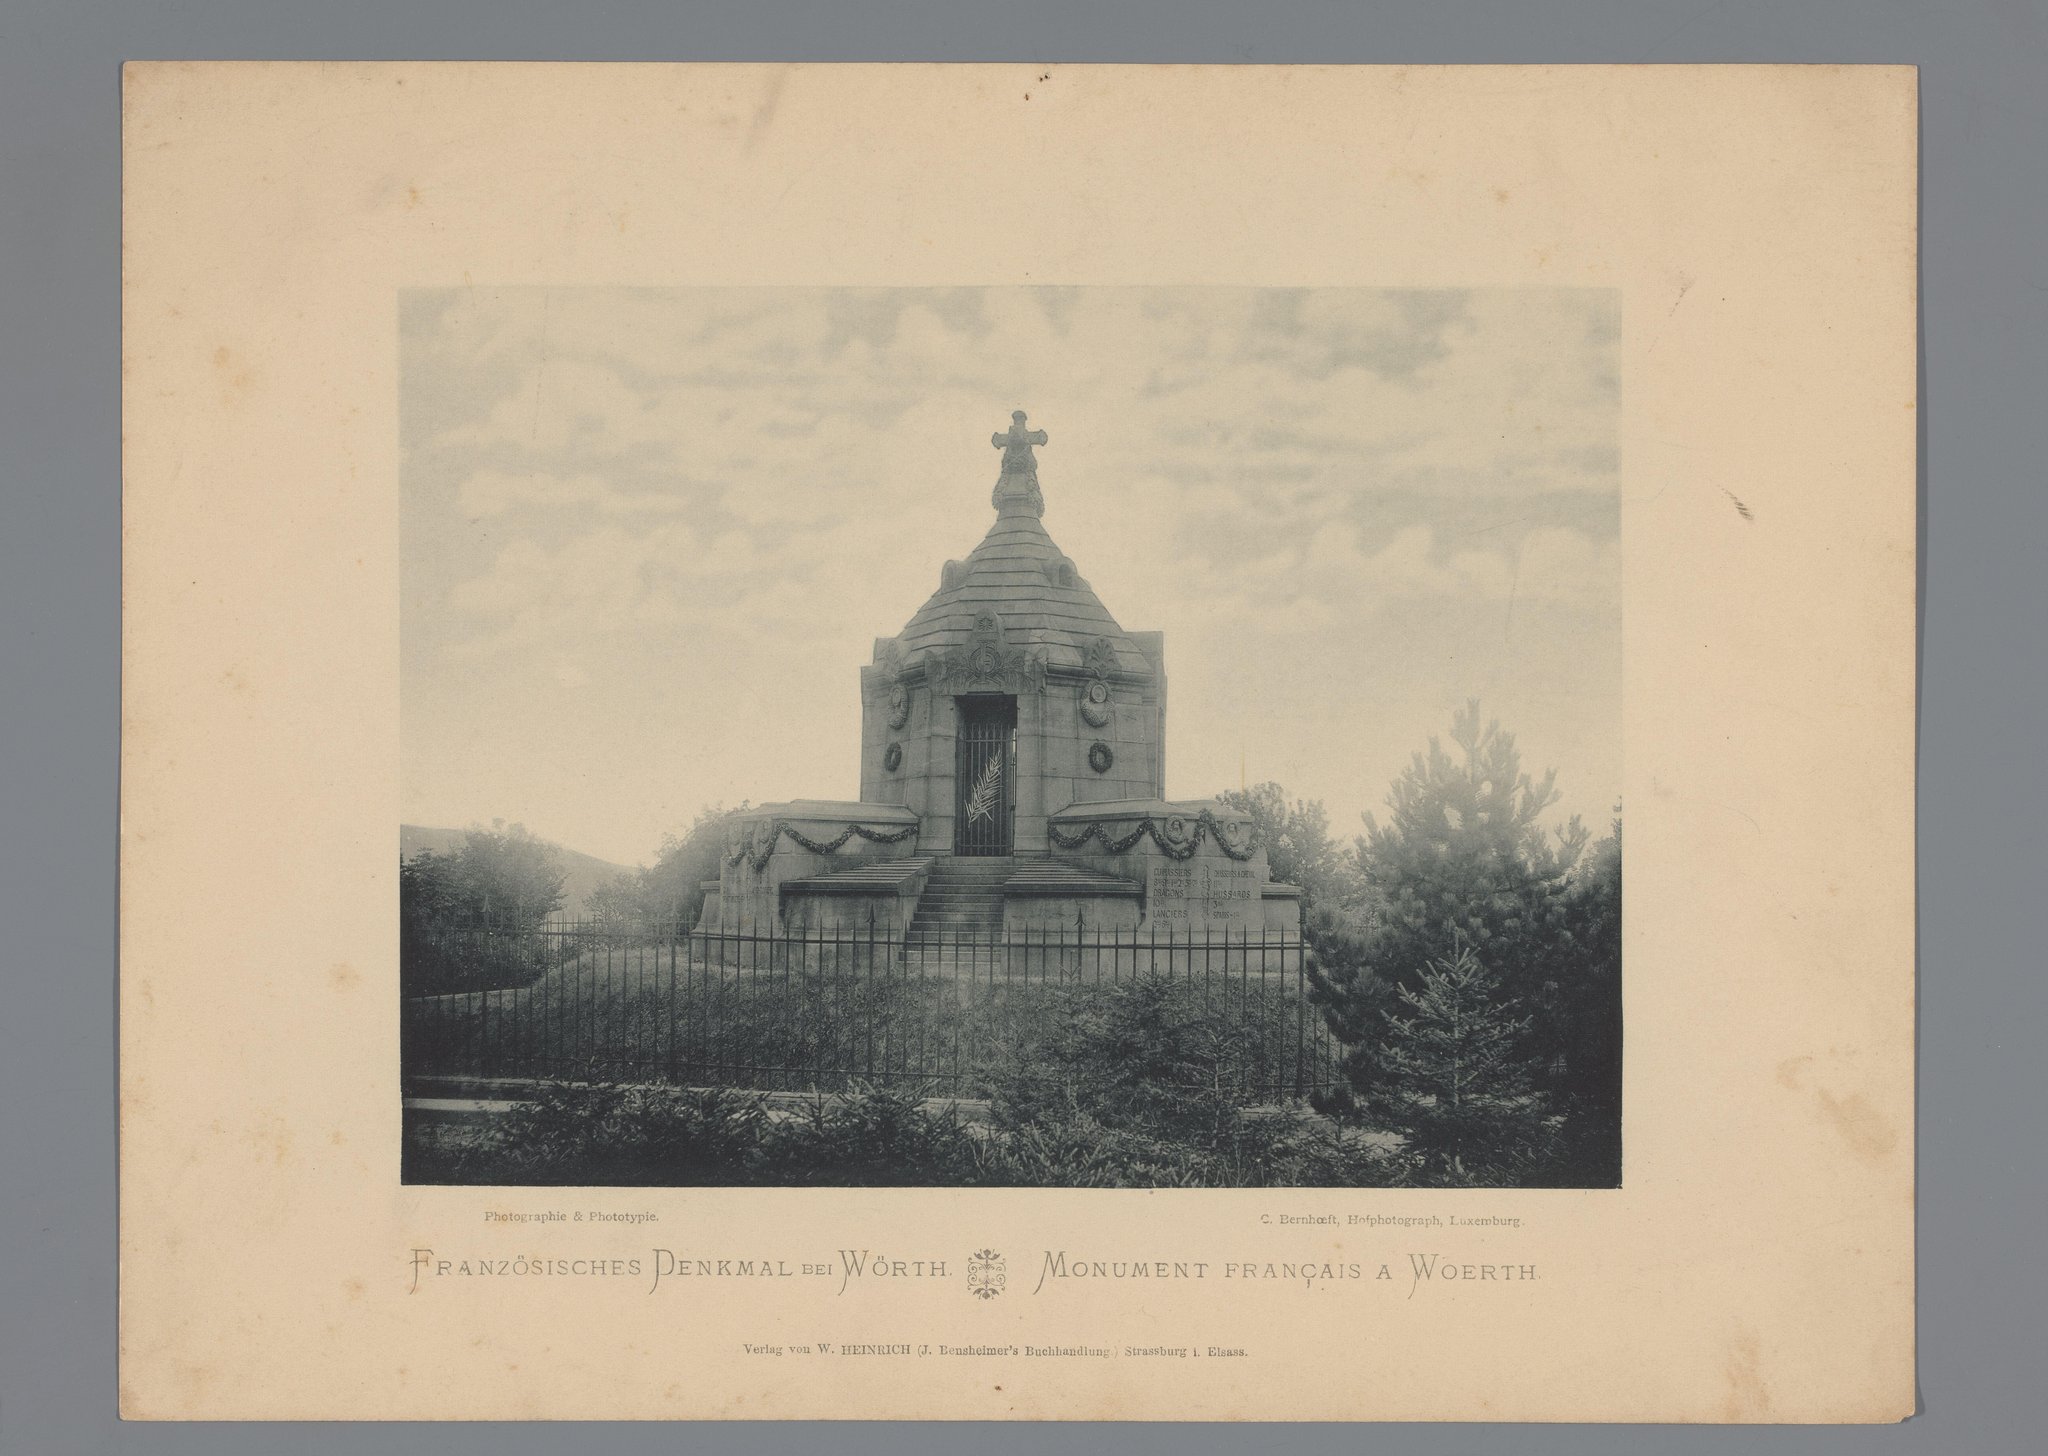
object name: photomechanical print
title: Herdenkingsmonument van Franse soldaten te Woerth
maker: charles bernhoeft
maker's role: publisher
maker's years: 1859-1933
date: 1889-1894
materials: paper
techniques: photograph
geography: straatsburg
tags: monument, statue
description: Deze prent maakt deel uit van een omslag met 100 prenten.